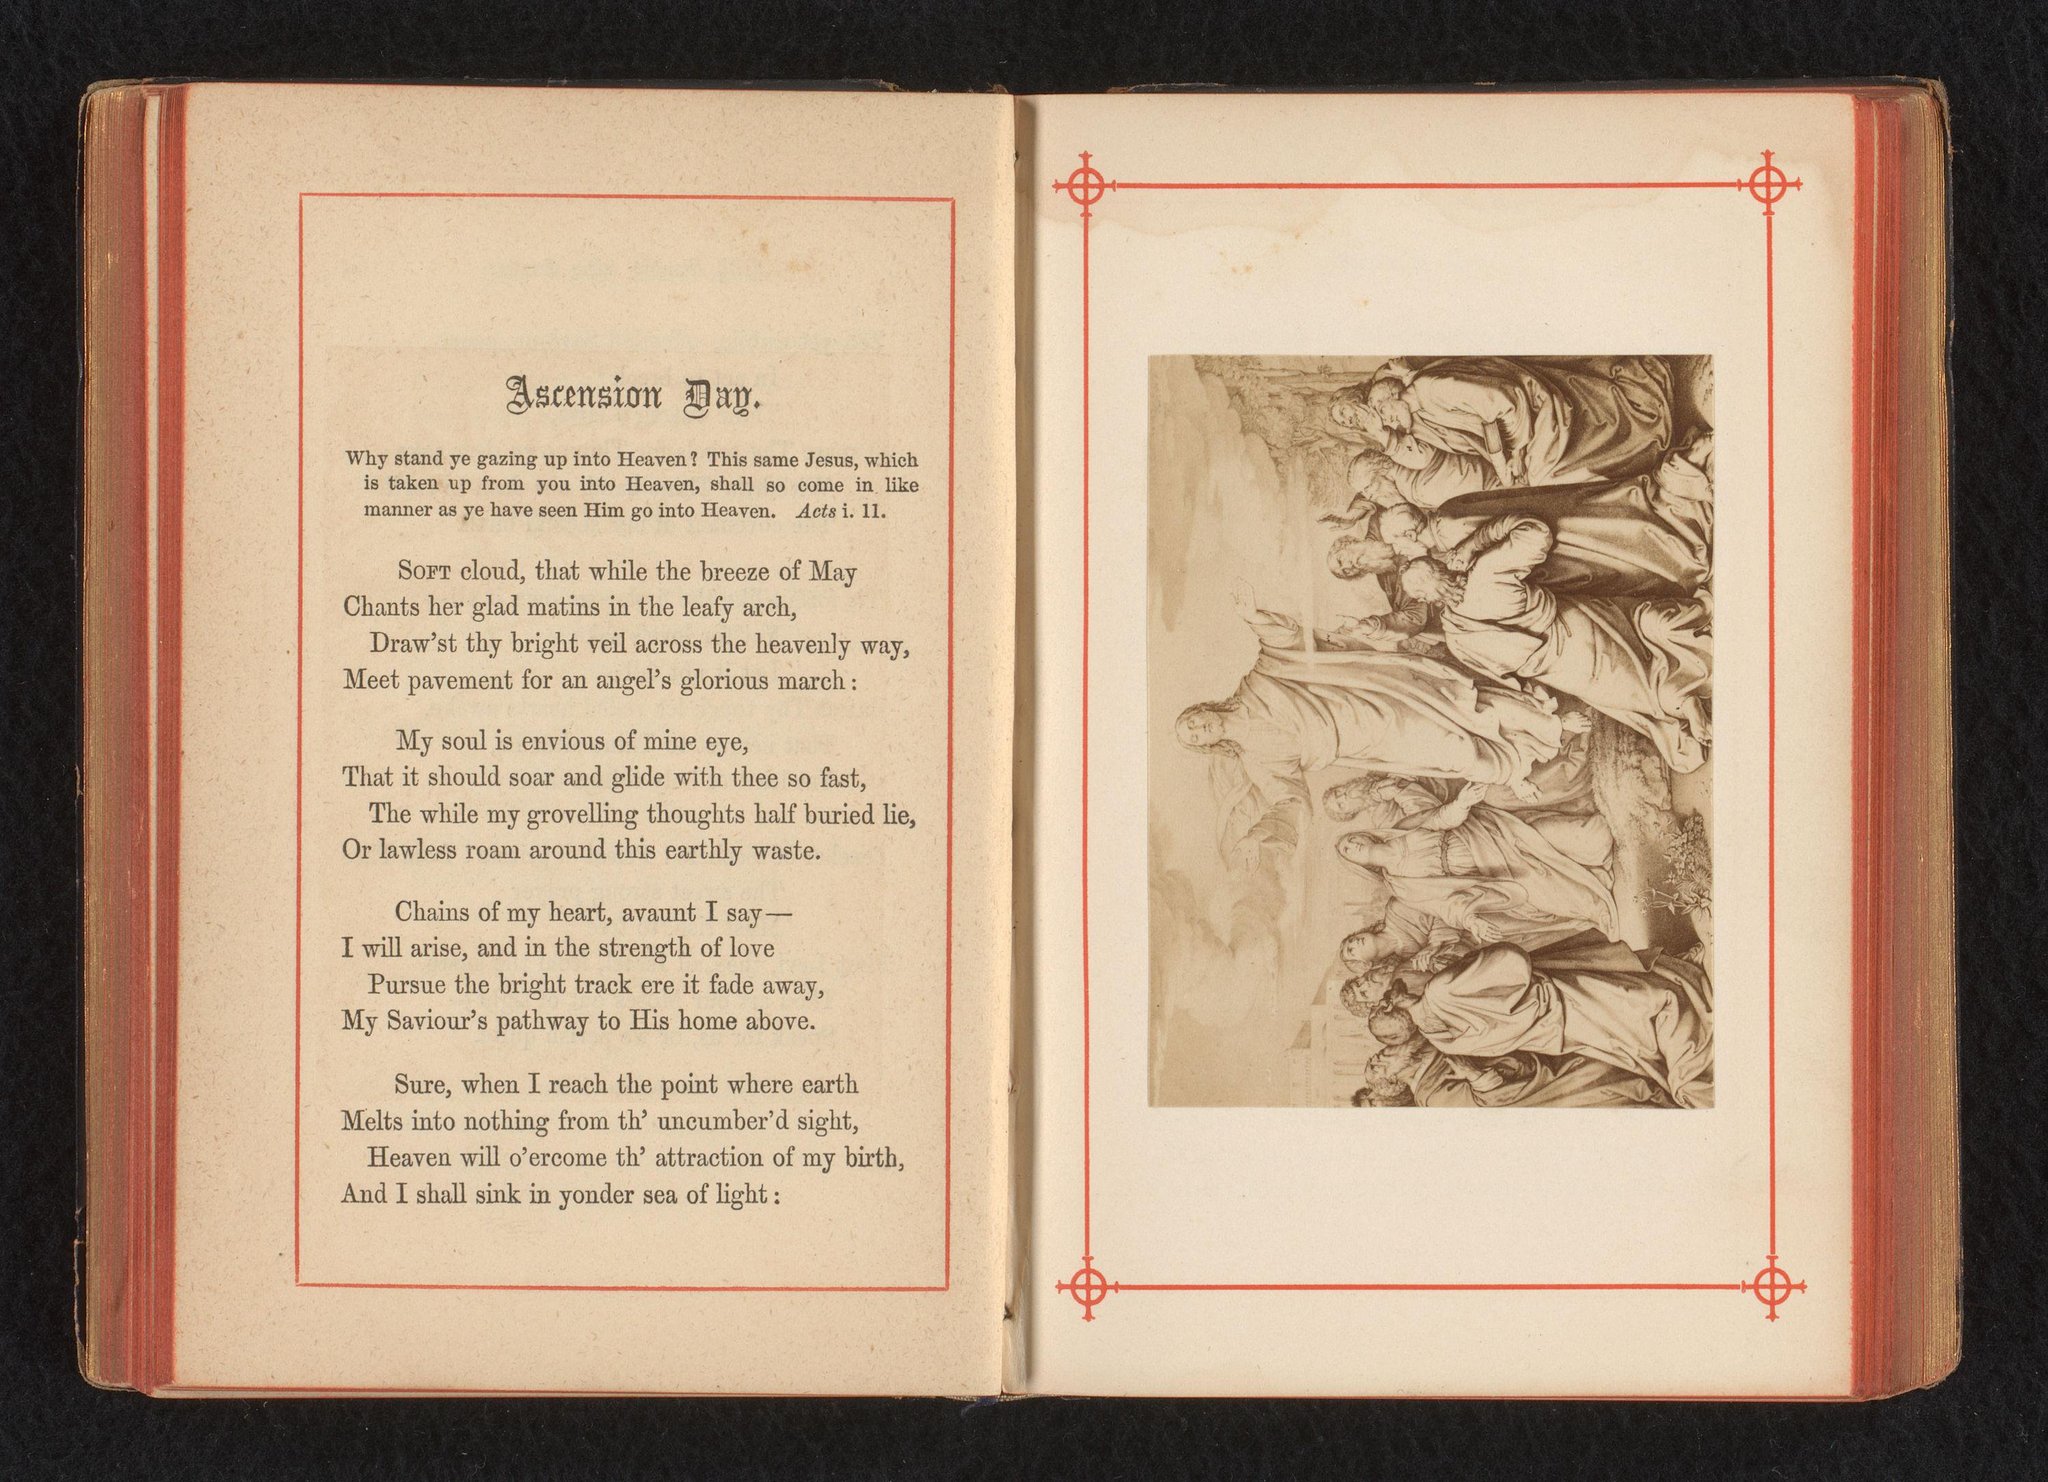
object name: reproduction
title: Fotoreproductie van een schilderij van de hemelvaart van Christus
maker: Anonymous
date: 1861-1866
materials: paper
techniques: albumen print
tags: the ascension (christ surrounded by radiant light or in a mandorla)